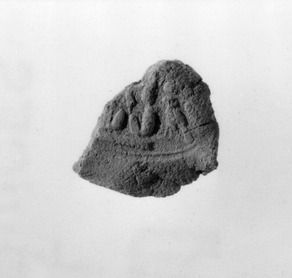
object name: sealing, nebmaatre, amenhotep iii, horus, re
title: Document Sealing With the Throne Name of Amenhotep III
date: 1390-1352 BCE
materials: mud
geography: egypt